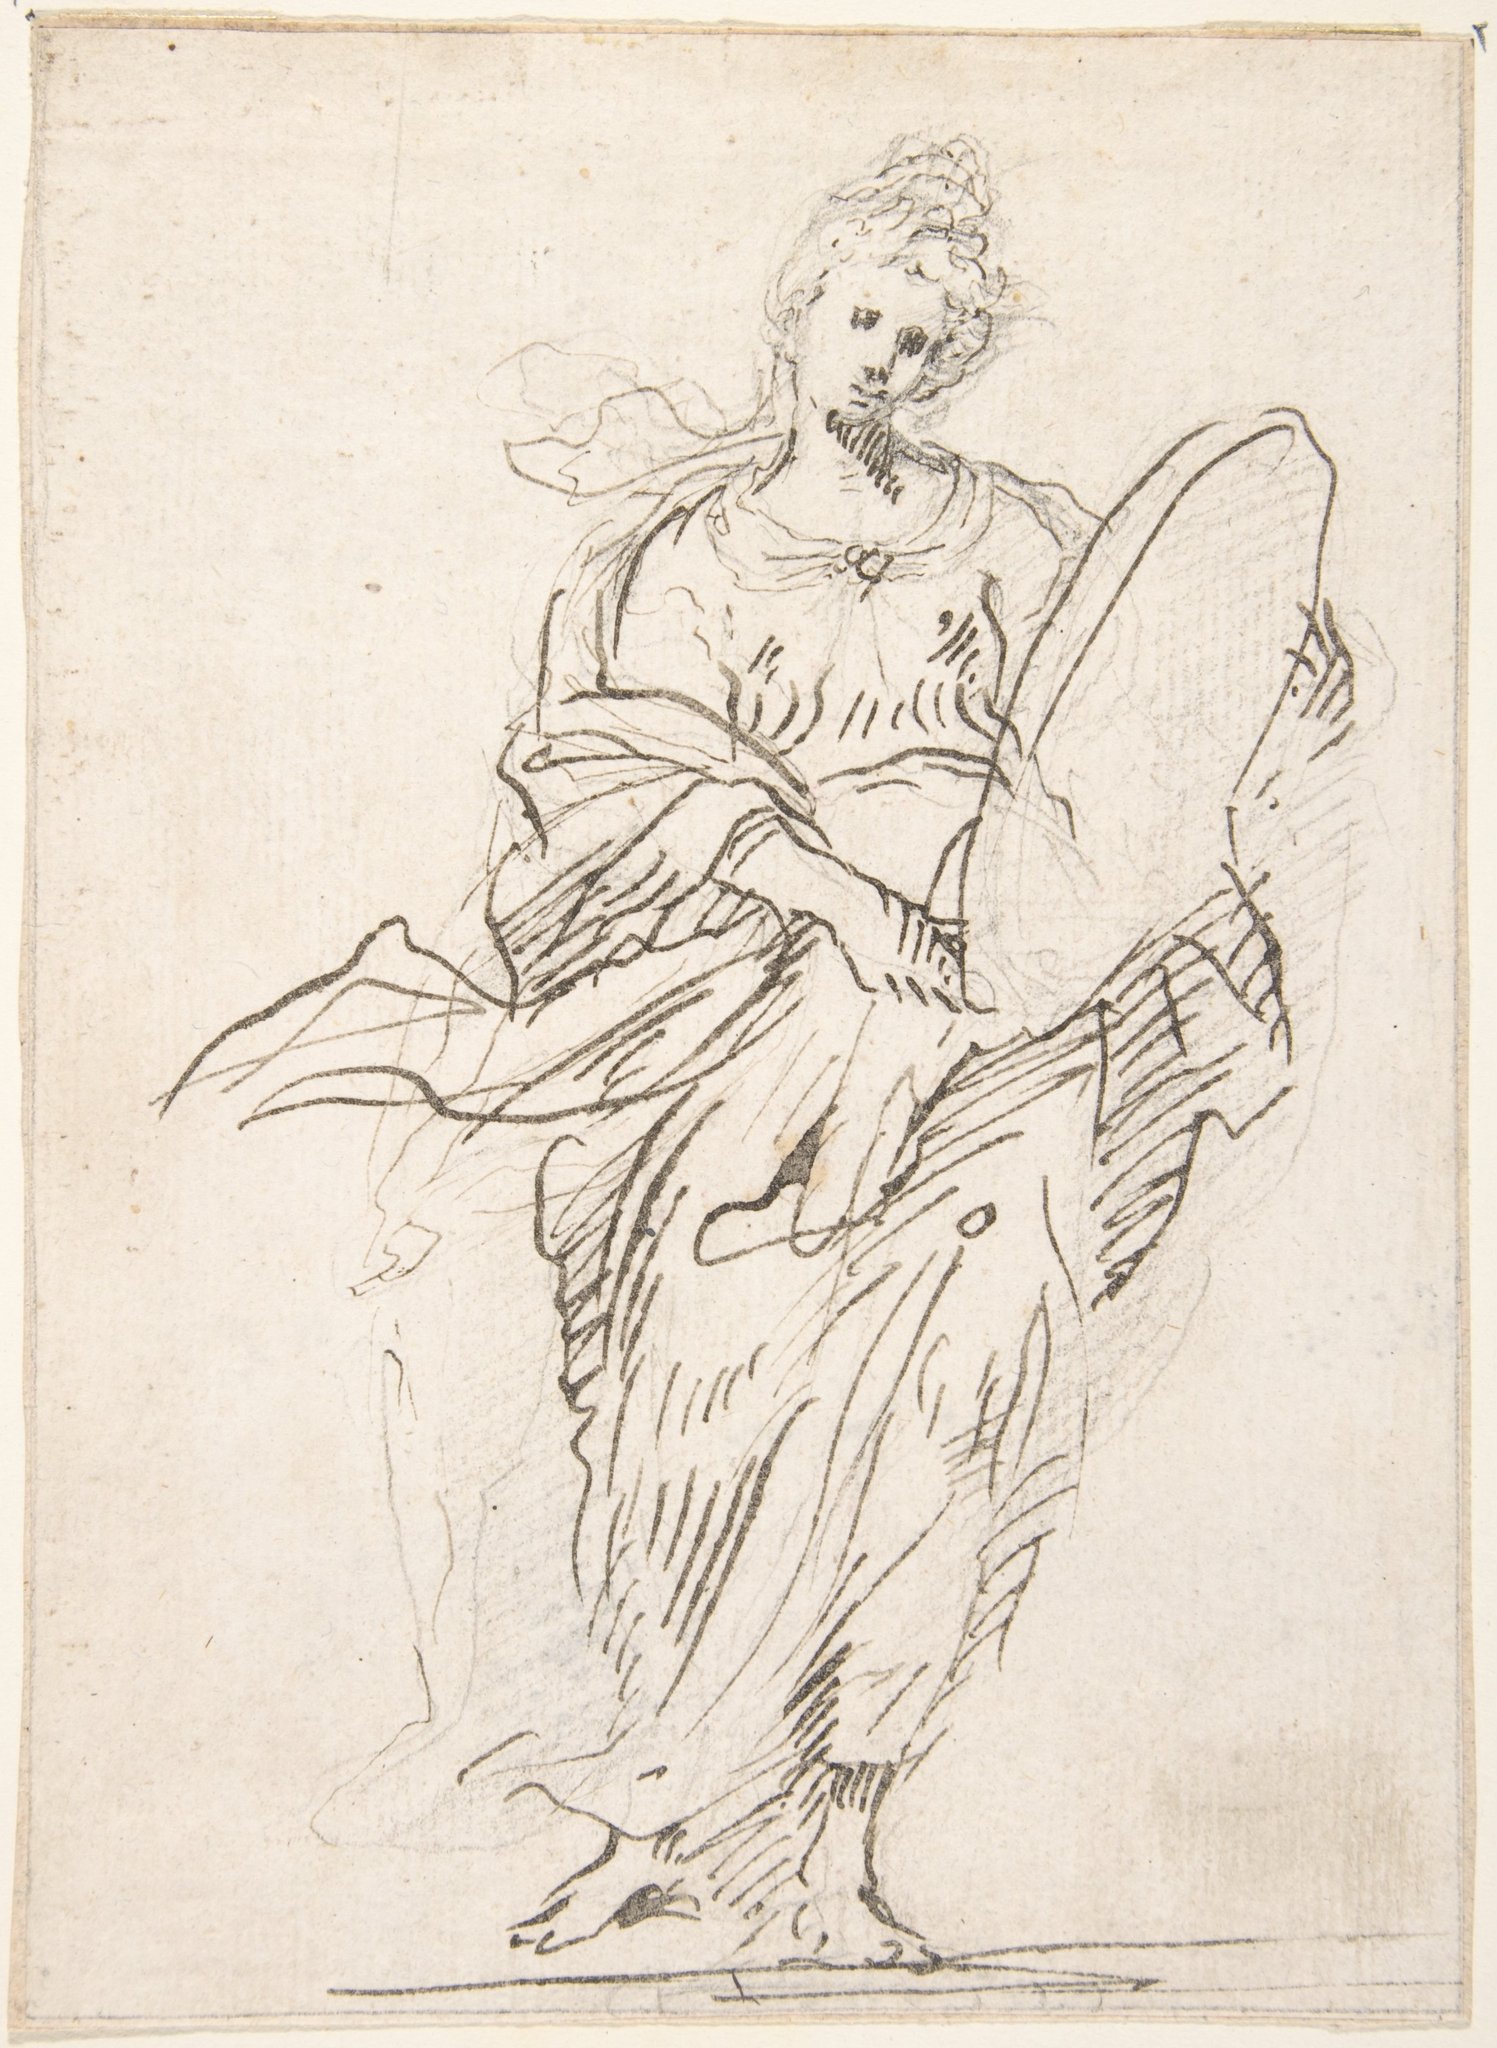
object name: drawing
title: Standing Female Figure with Large Medallion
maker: pedro duque cornejo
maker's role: artist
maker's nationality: spanish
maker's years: 1677-1757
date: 1700-1750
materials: chalk, ink, paper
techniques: pen, drawing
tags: women